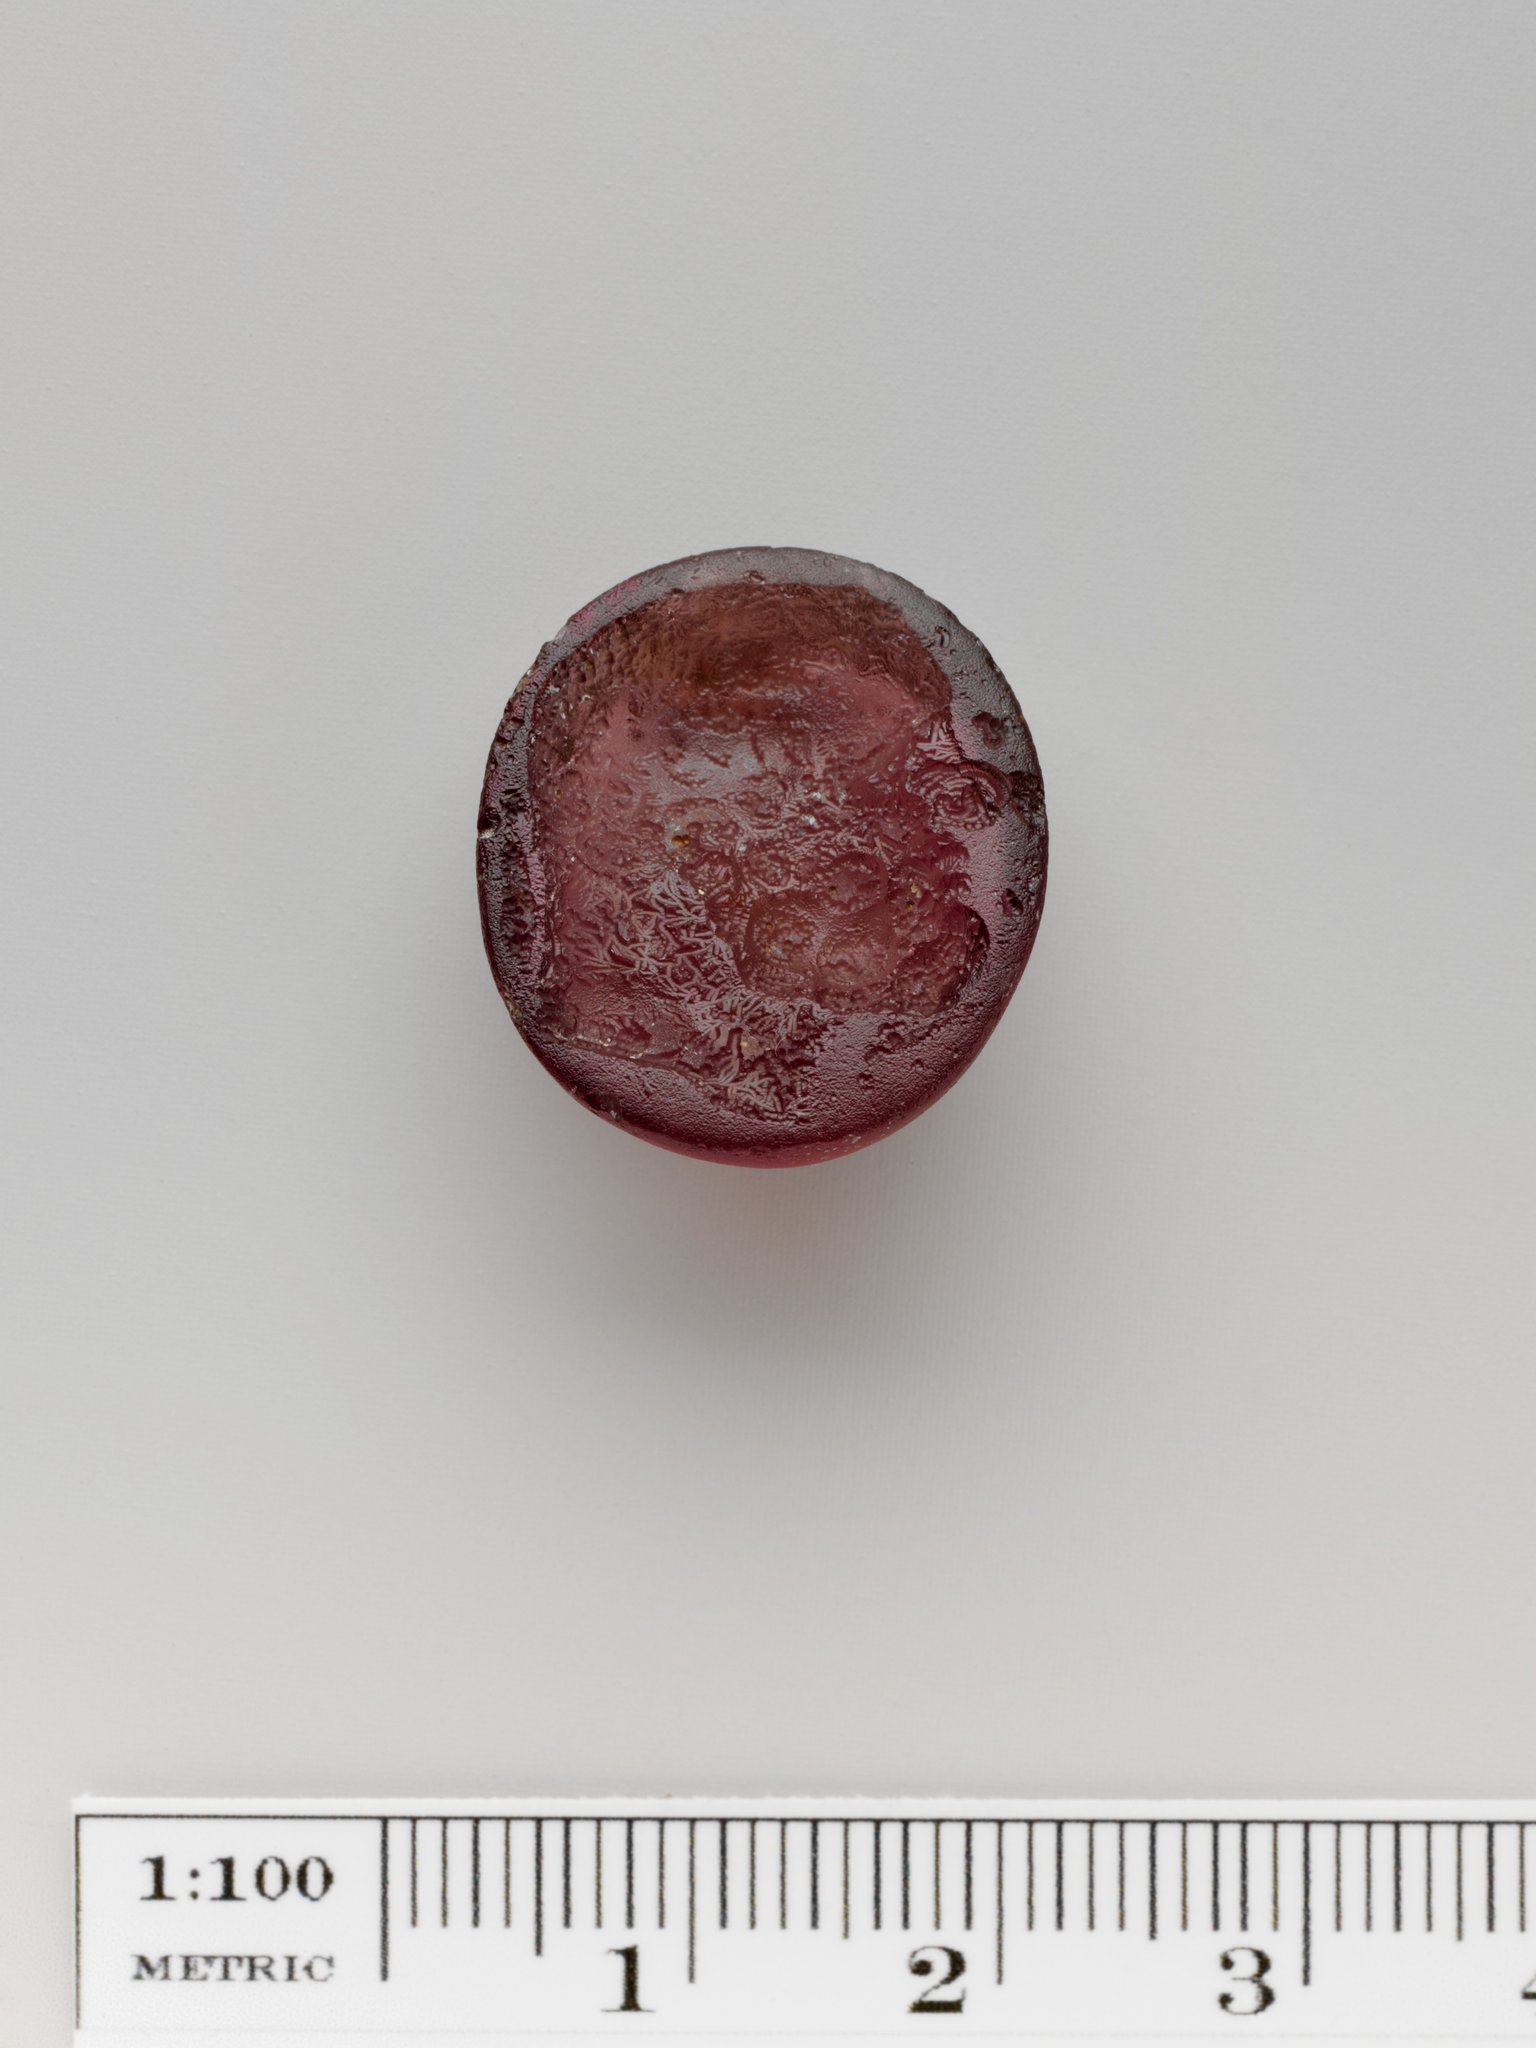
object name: intaglio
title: Glass ring stone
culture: greek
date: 300-1 BCE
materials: glass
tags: heads,herakles